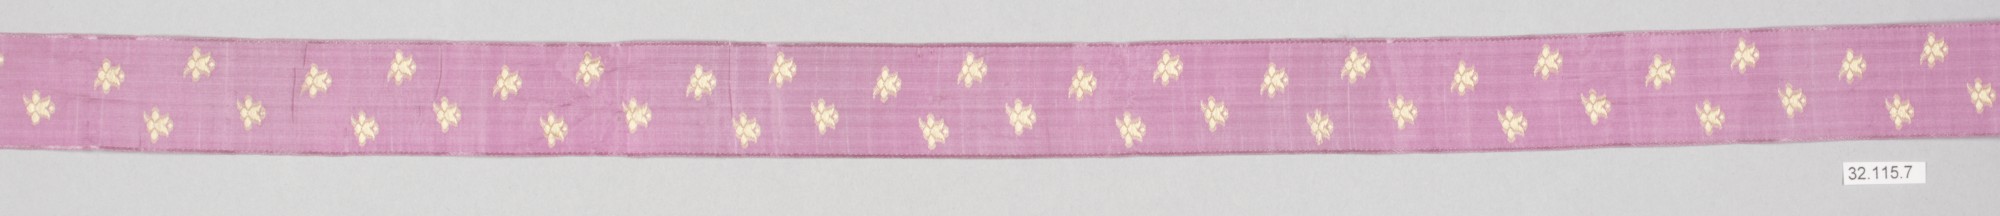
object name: ribbon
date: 1860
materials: silk